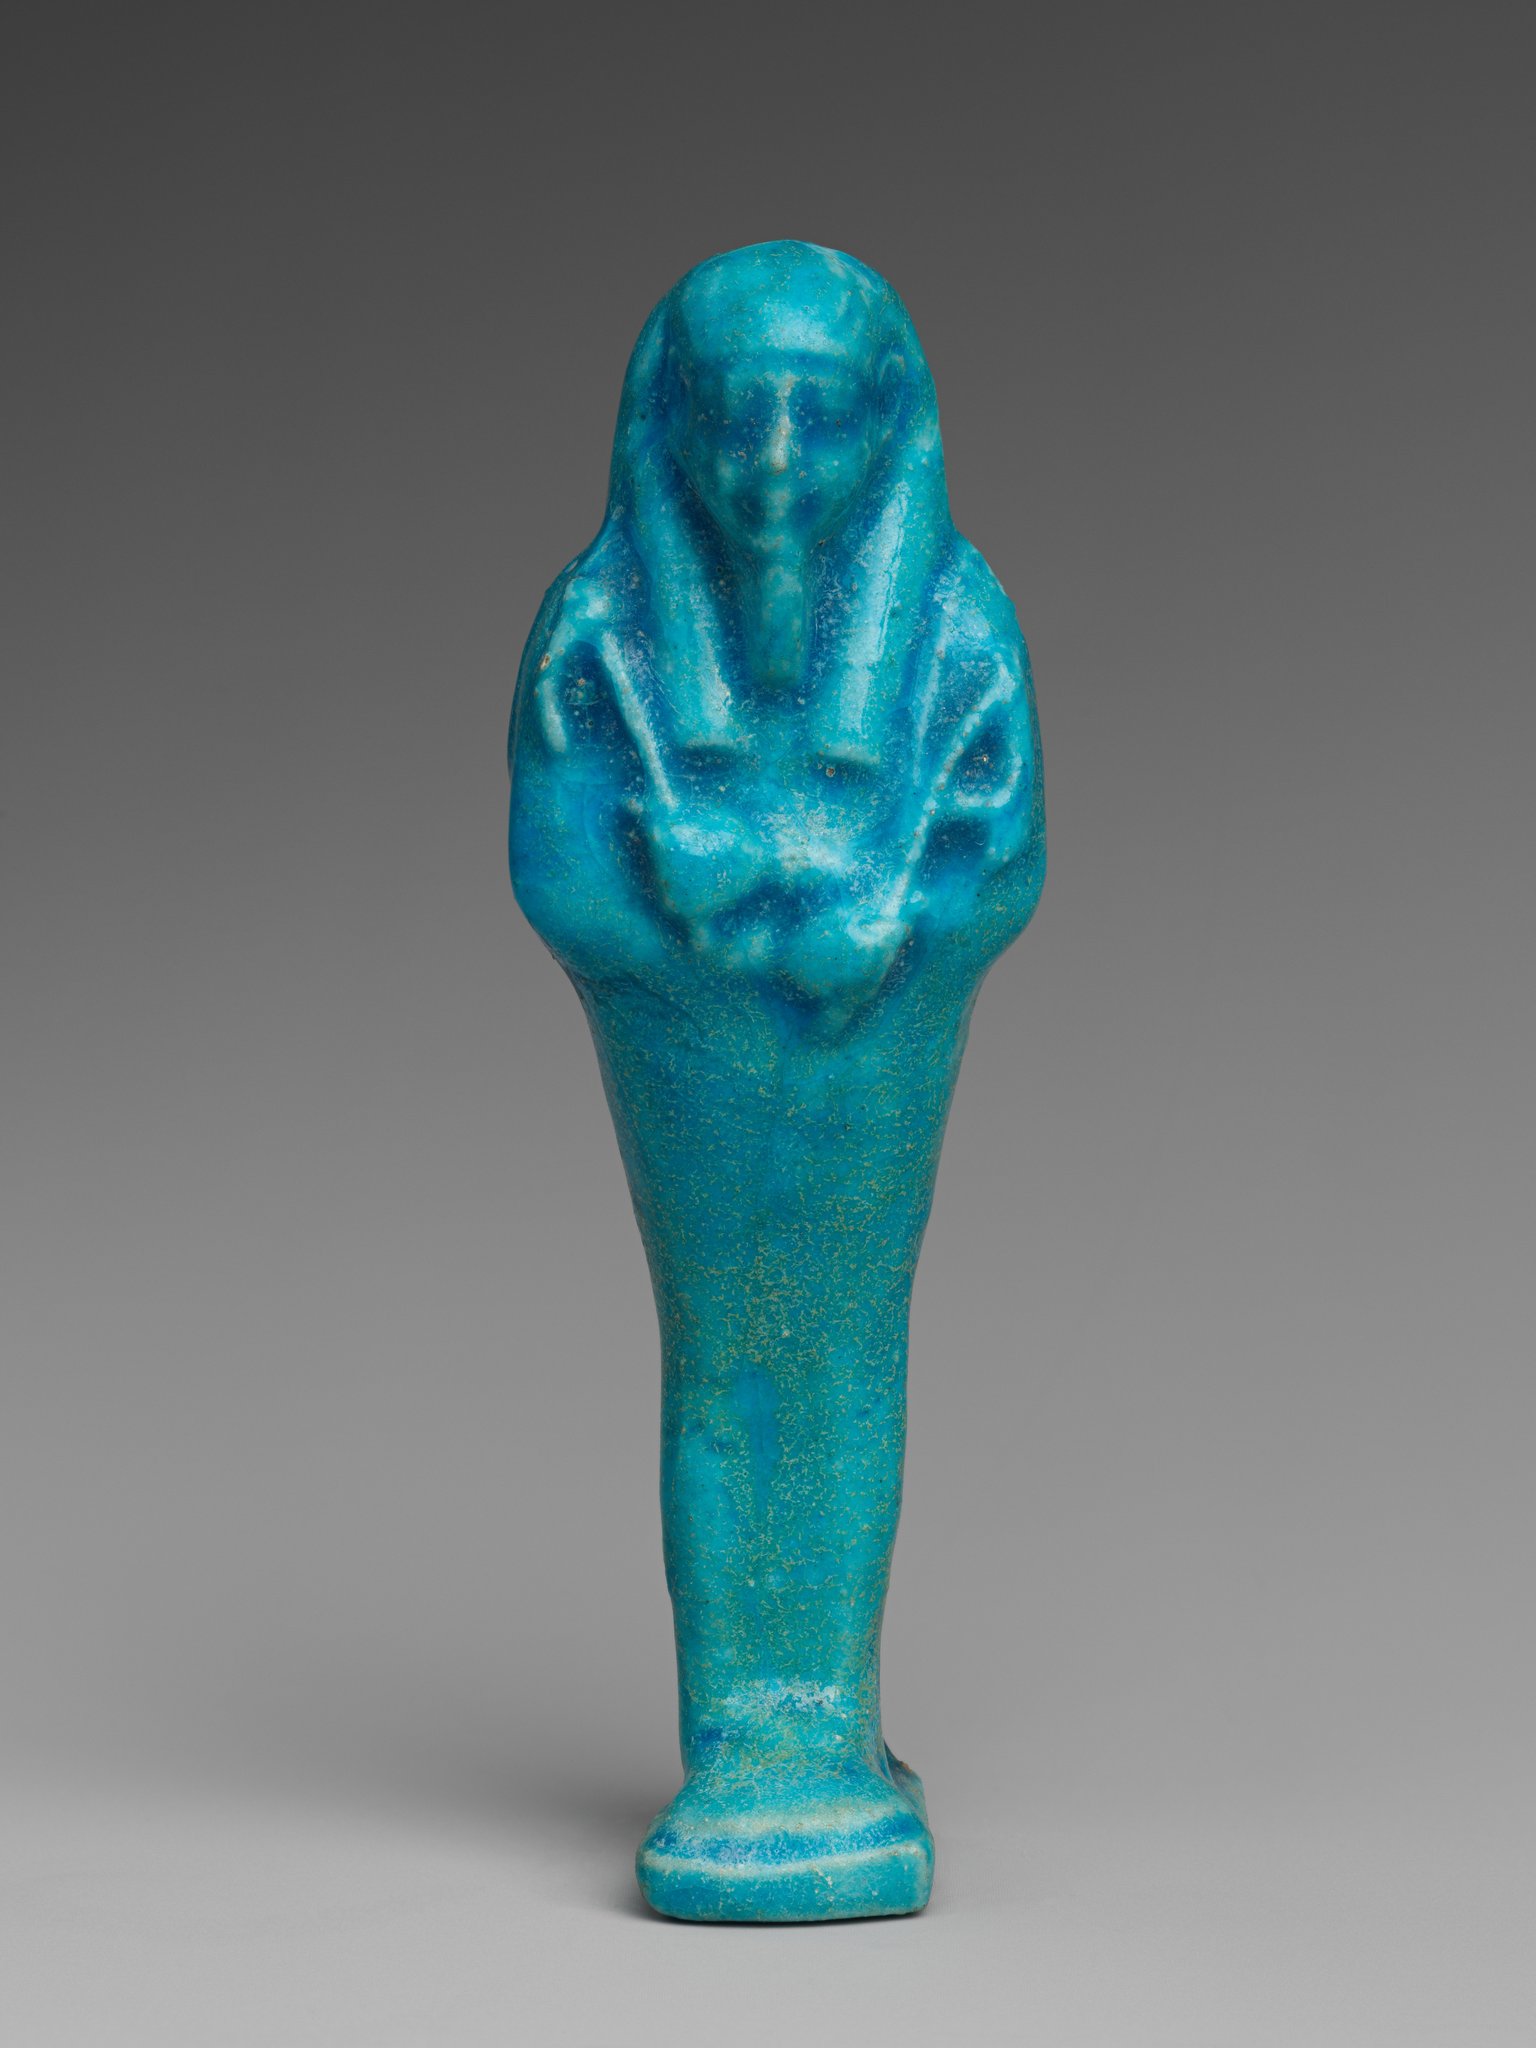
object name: shabti, petosiris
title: Shabti of Petosiris, son of Djedhor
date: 360-300 BCE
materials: faience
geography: egypt